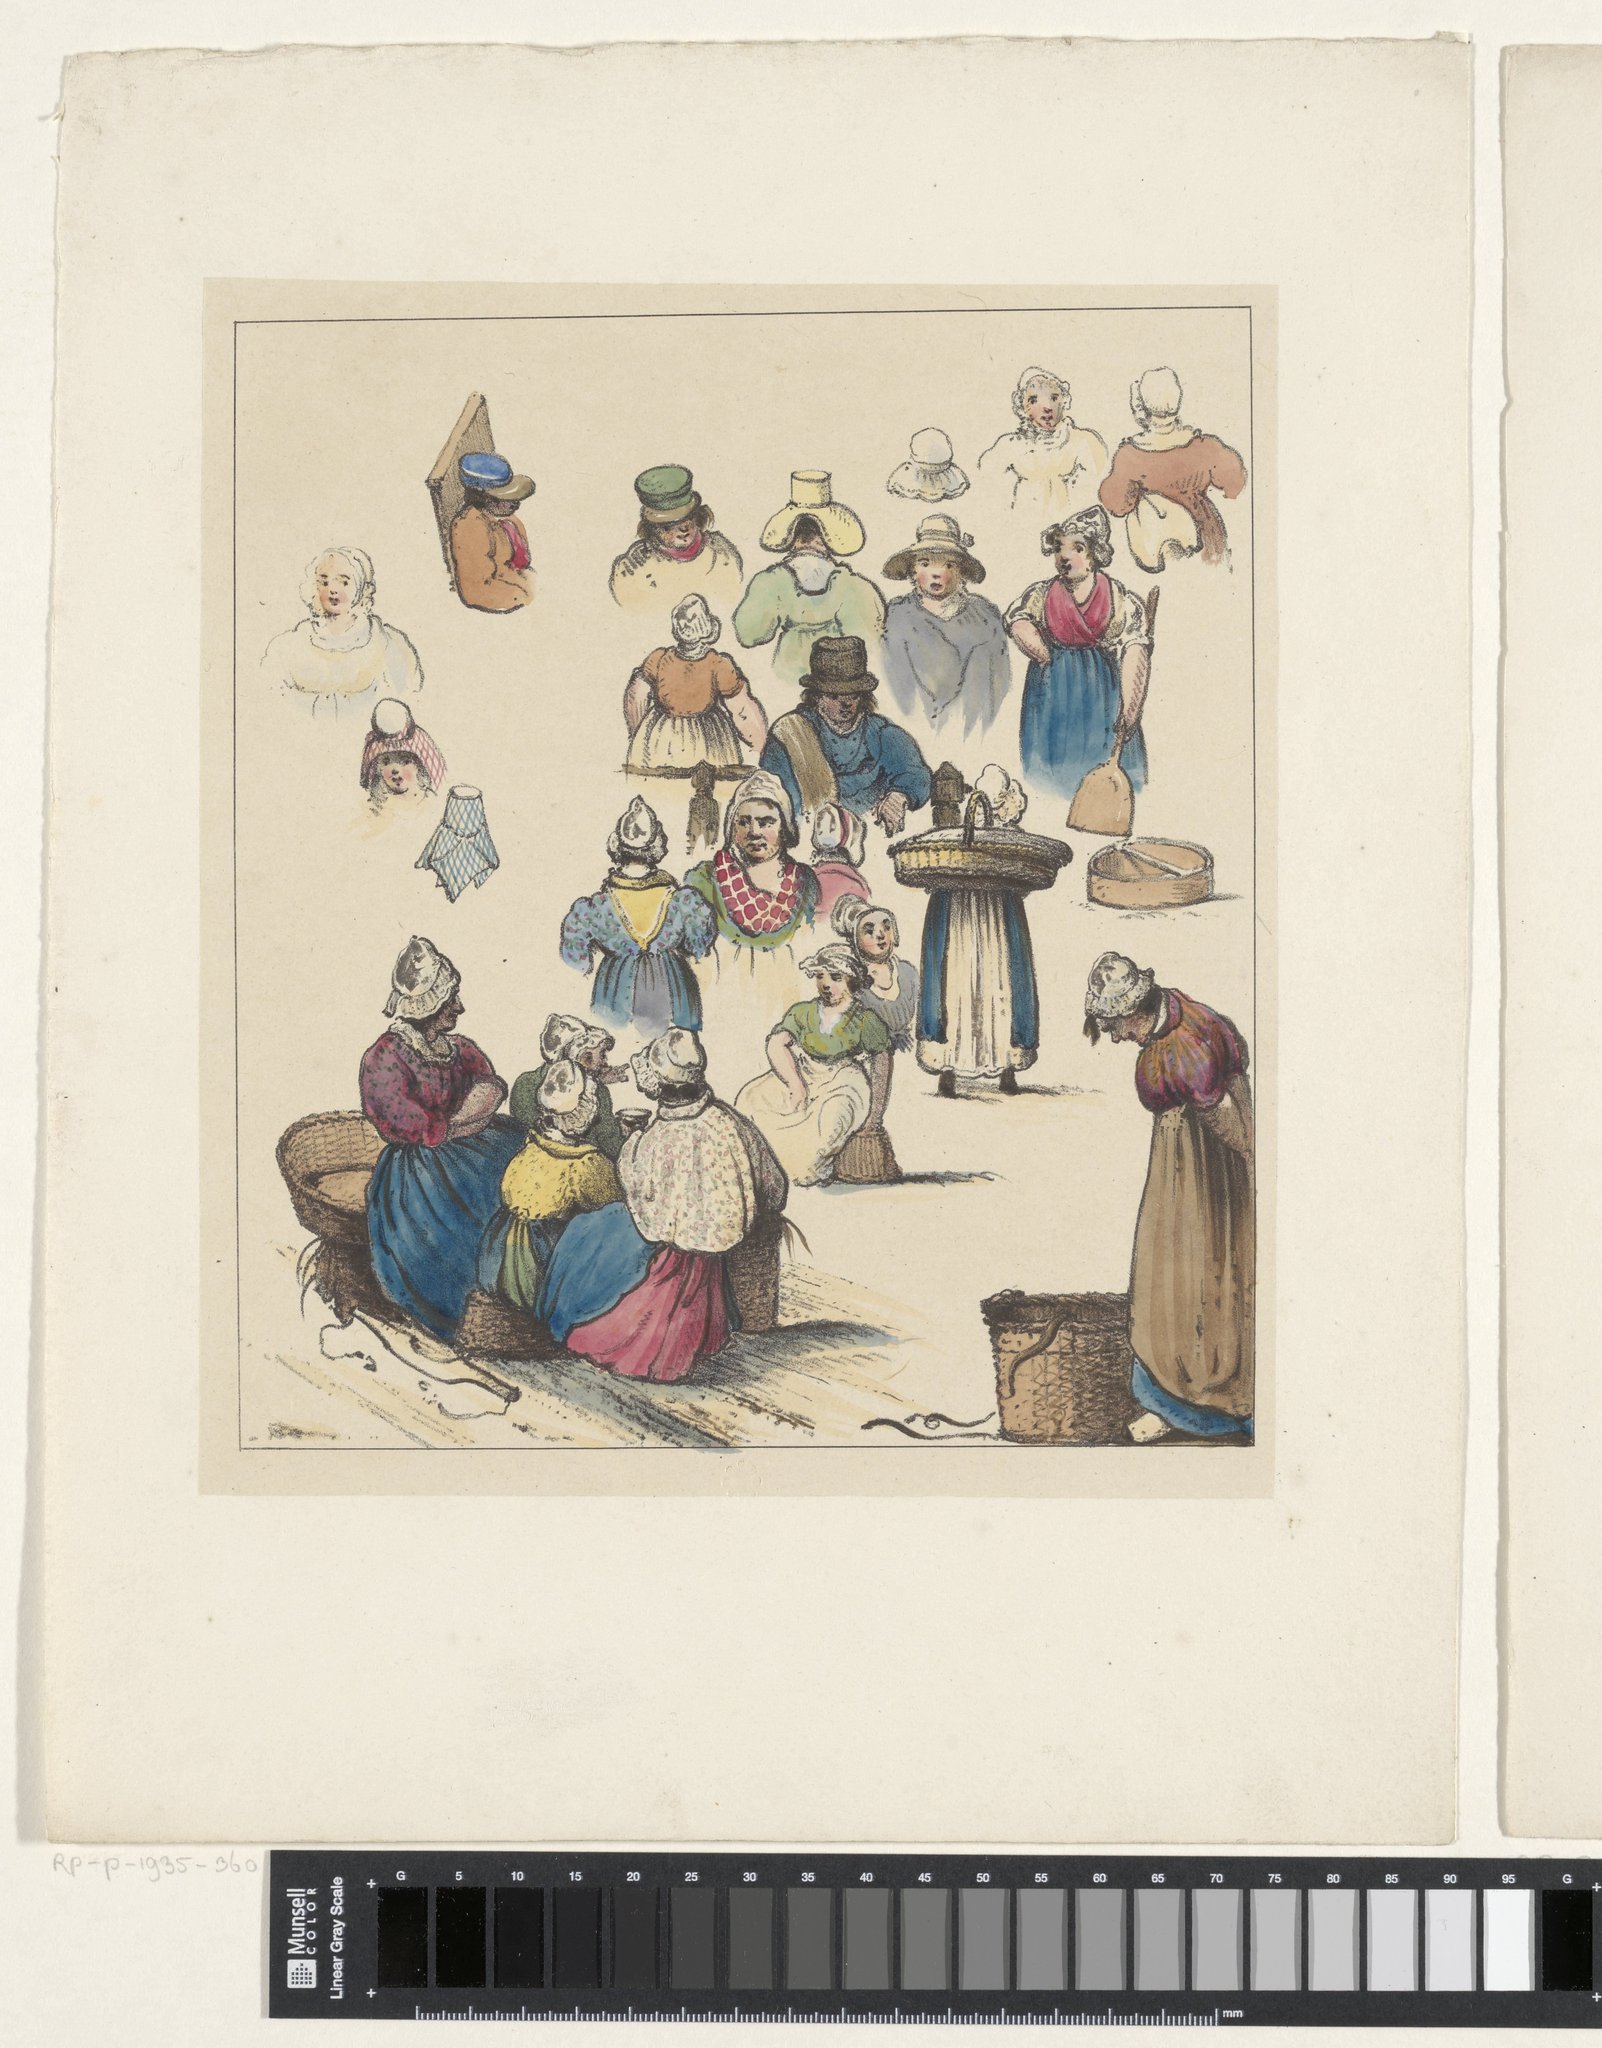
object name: print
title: Figuurstudies (derde blad), 1833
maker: christiaan andriessen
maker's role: draughtsman, print maker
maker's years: 1775-1846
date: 1833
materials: paper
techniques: hand coloring, lithograph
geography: amsterdam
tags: street-trader, folk costume, regional costume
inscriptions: collector's mark:, collector's mark: Lugt 2760, collector's mark: Lugt 2228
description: Blad met figuren: linksonder een groep vrouwen zittend op en bij manden, rechtsonder een staande vrouw bij een mand met palingen. Onderdeel van een serie van zes bladen met figuurstudies van Nederlandse klederdrachten, straatfiguren en gebuiken, 1833.